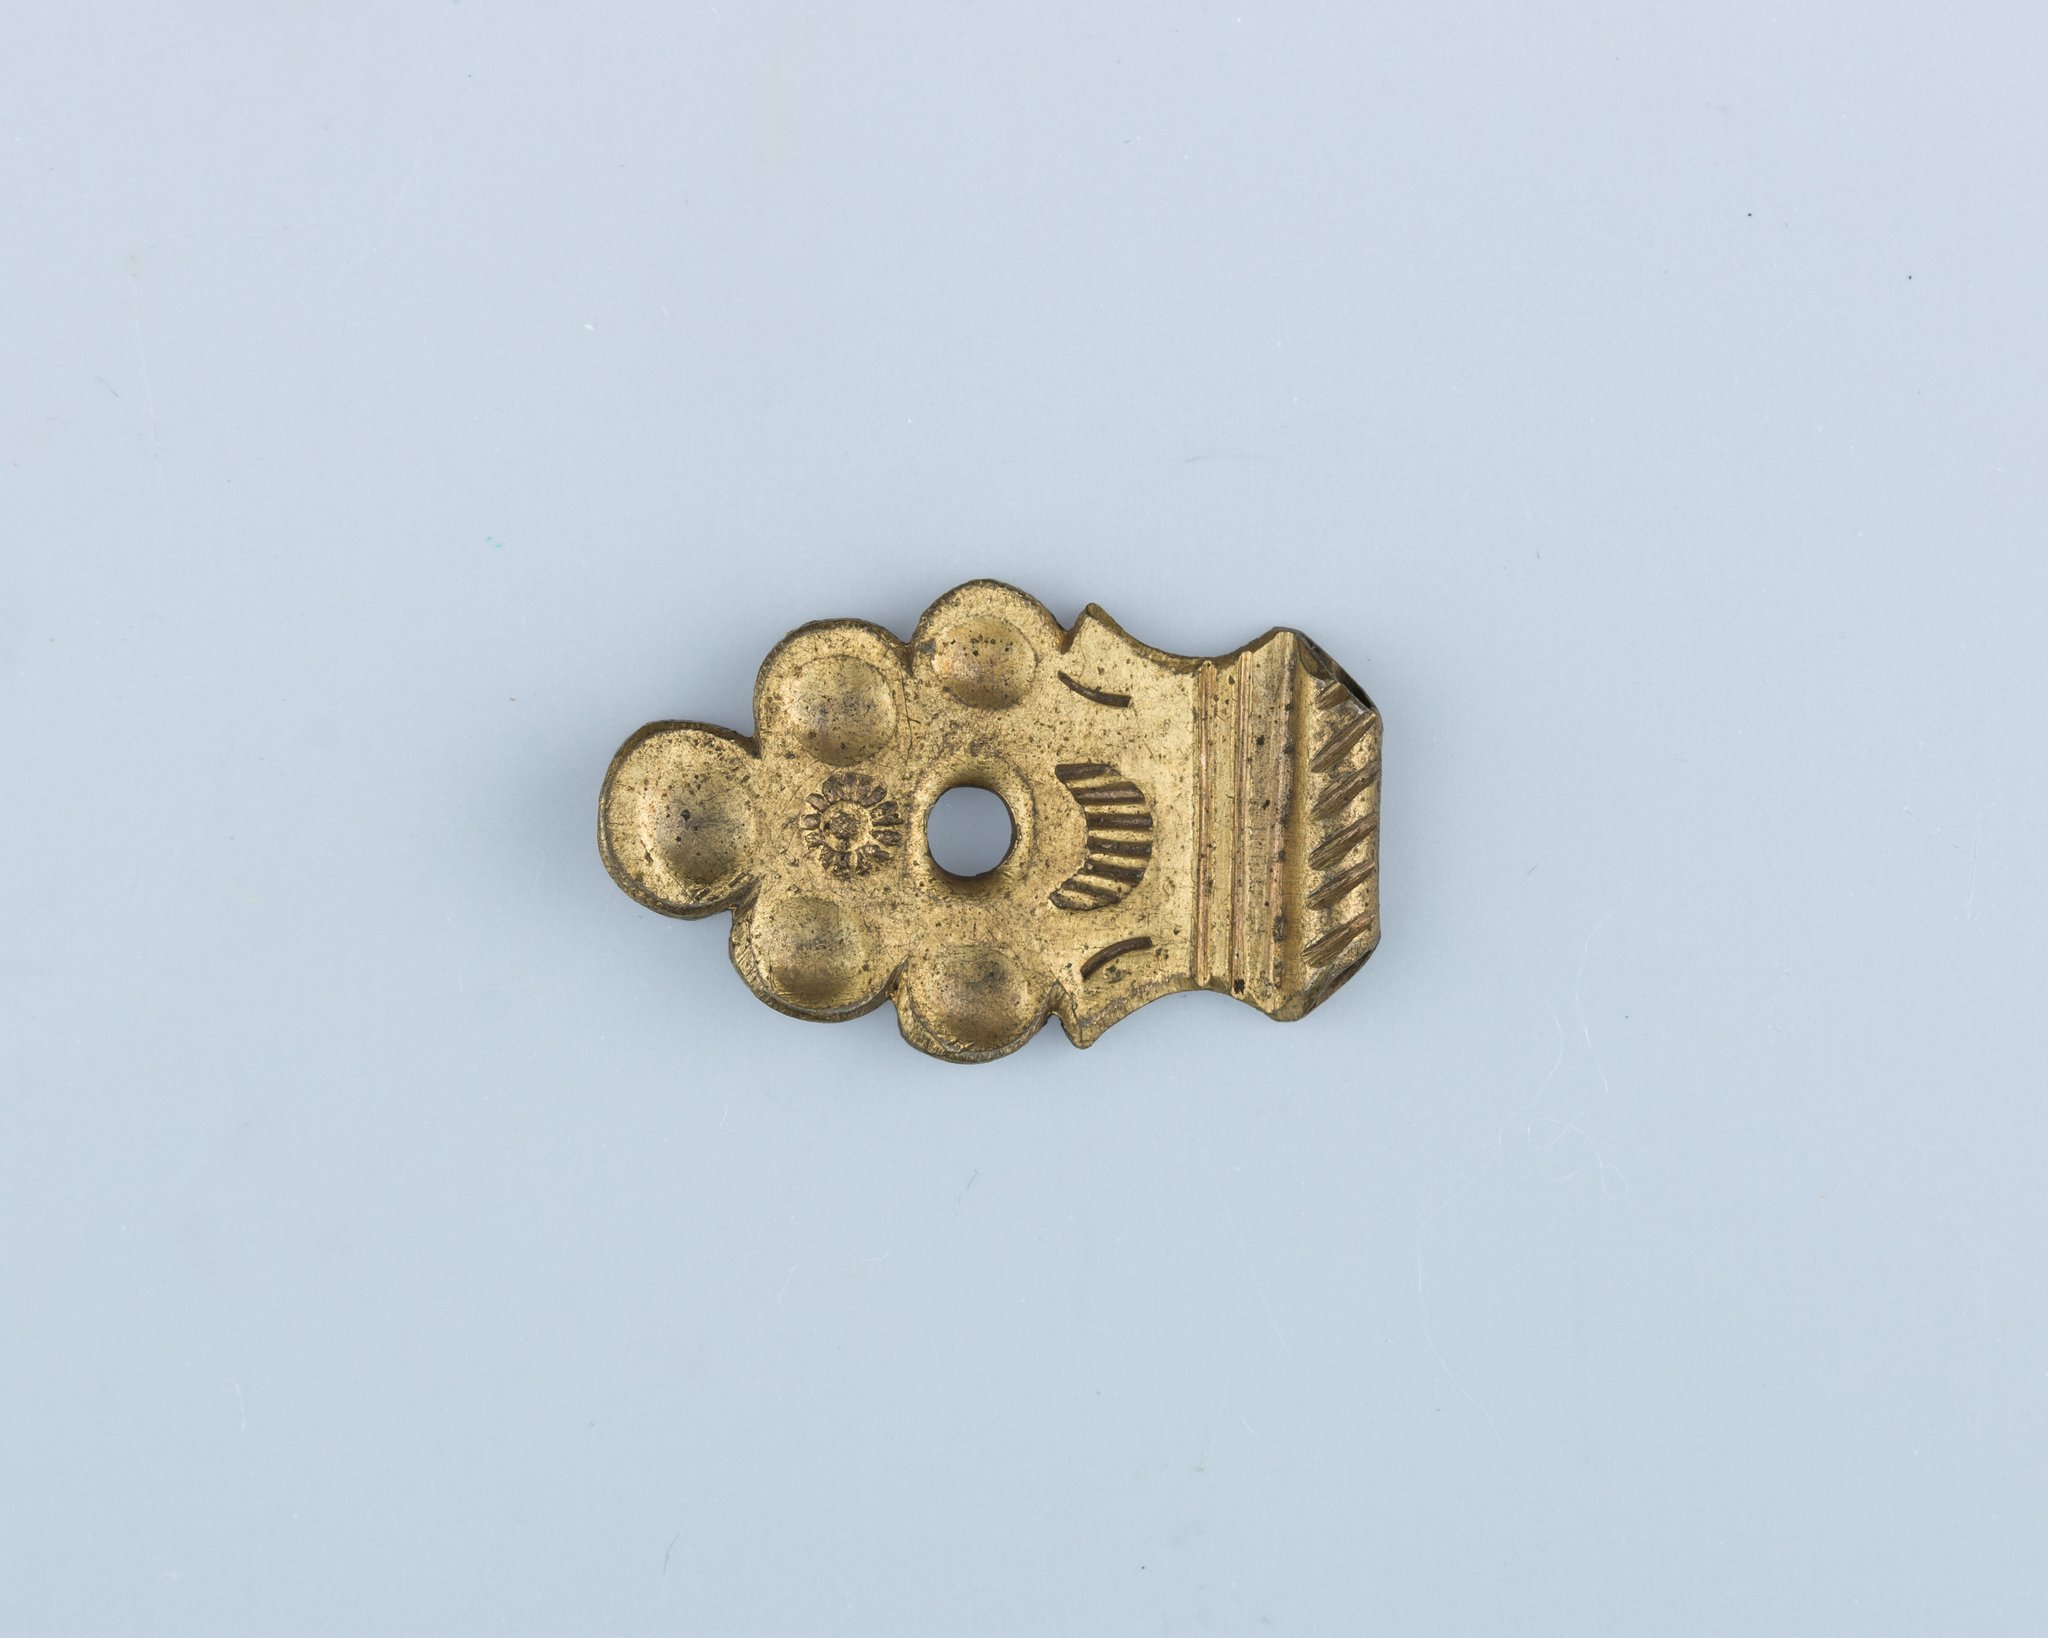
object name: mordant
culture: german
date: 1501-1600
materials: brass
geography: germany